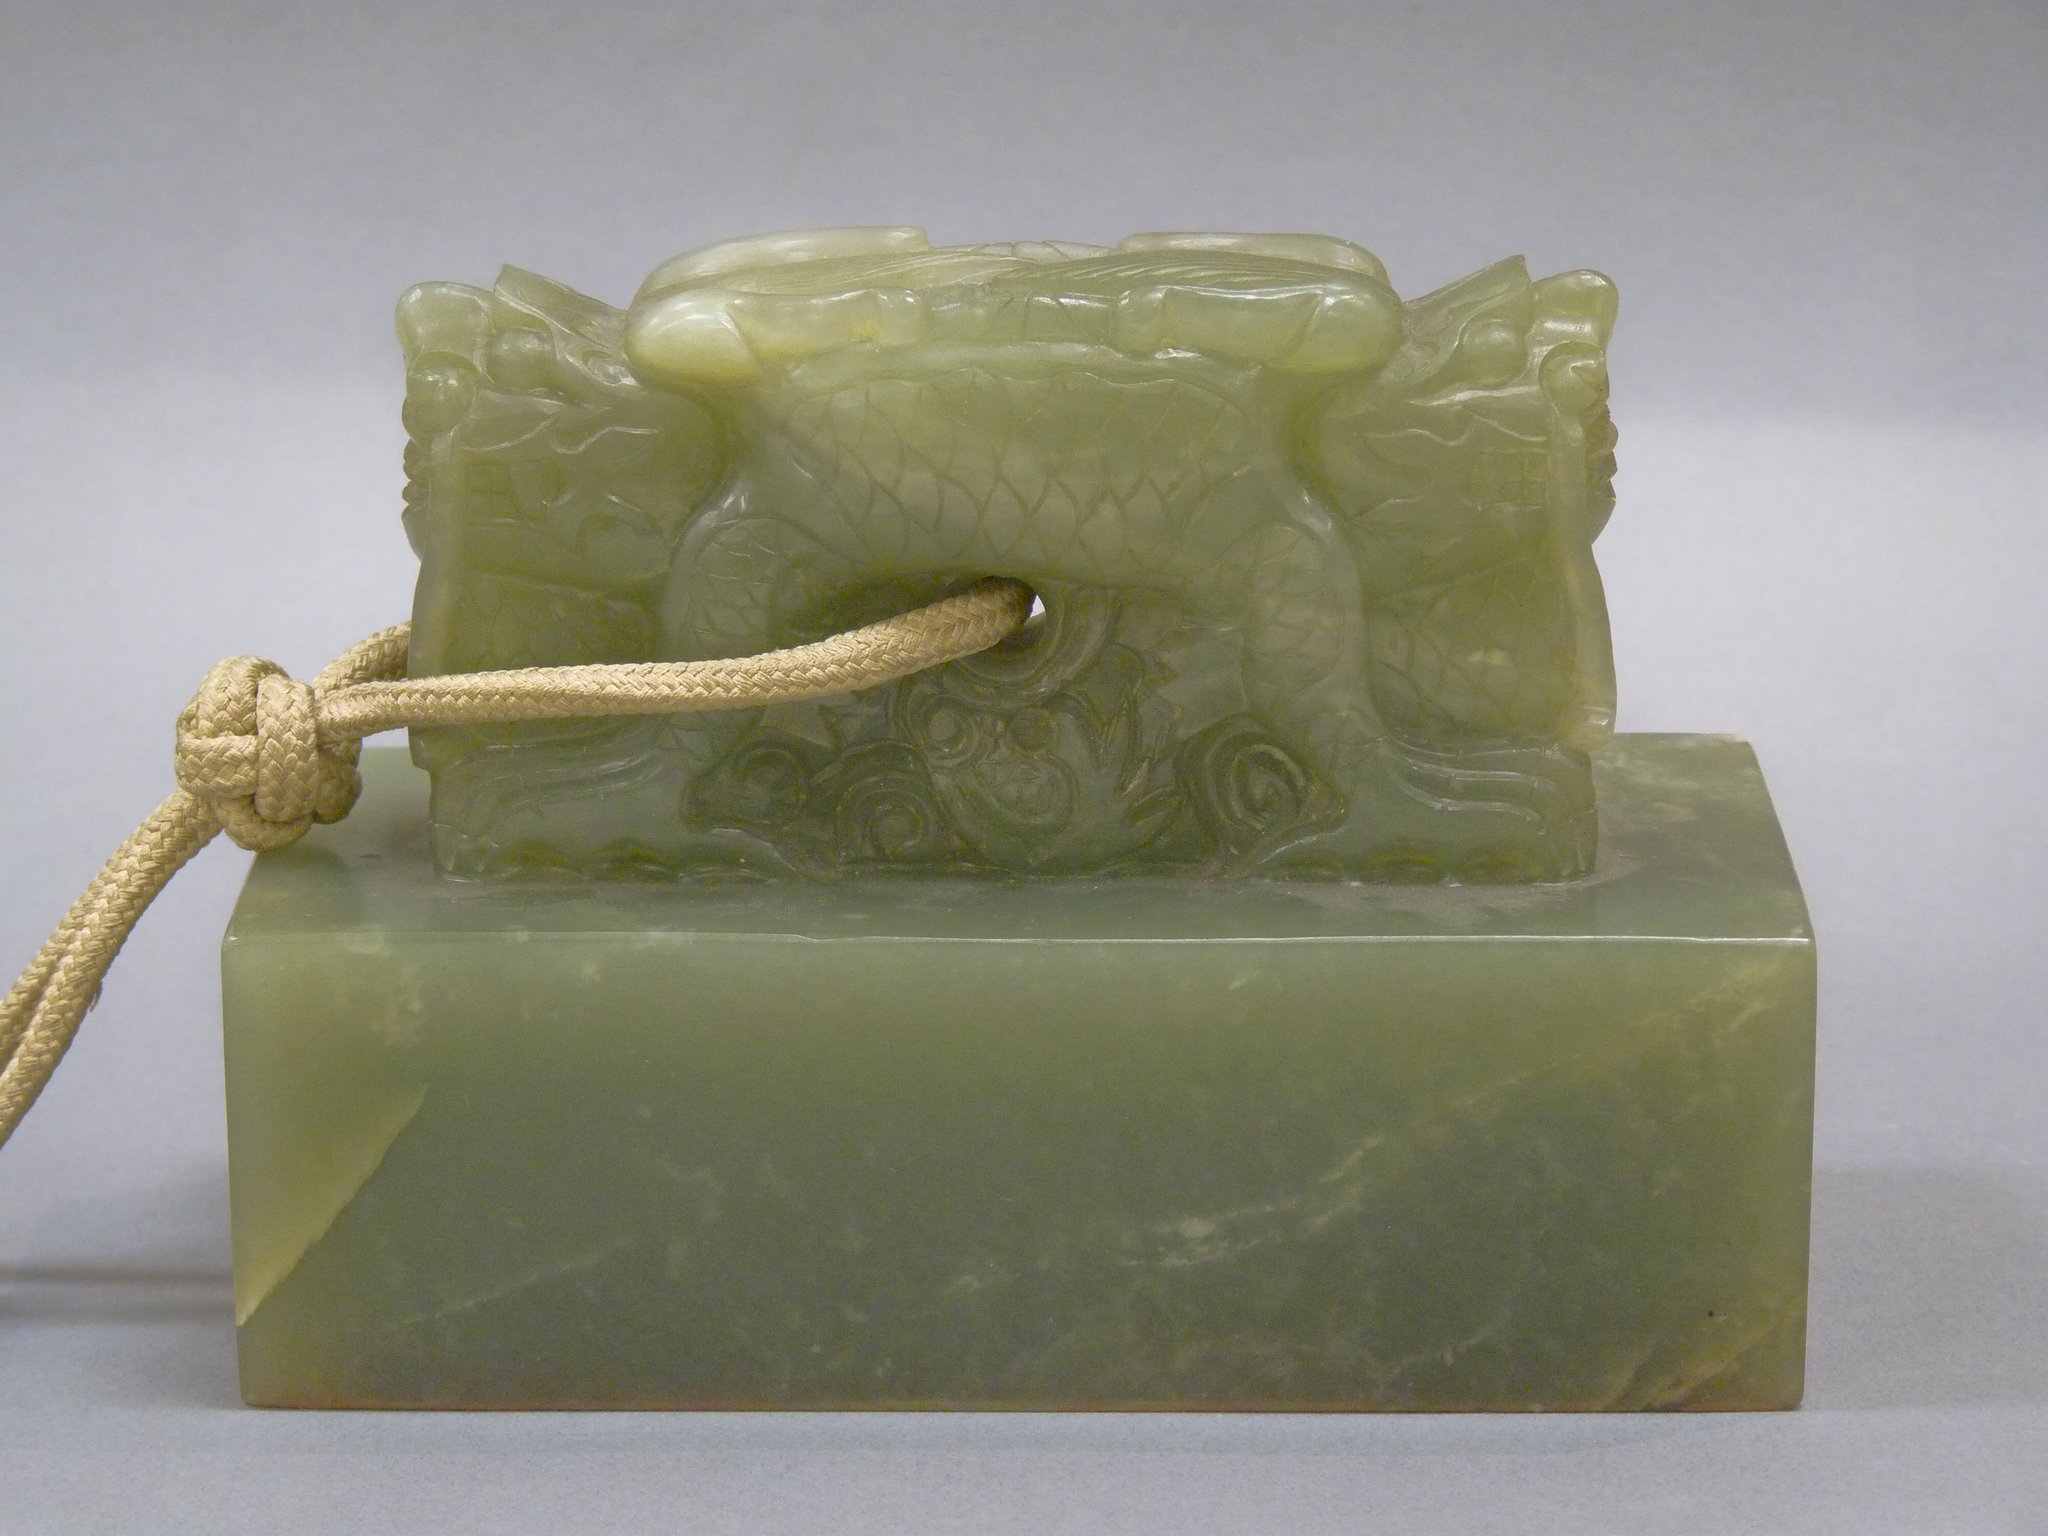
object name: seal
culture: chinese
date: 1801-1900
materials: jade, silk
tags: mythical creatures